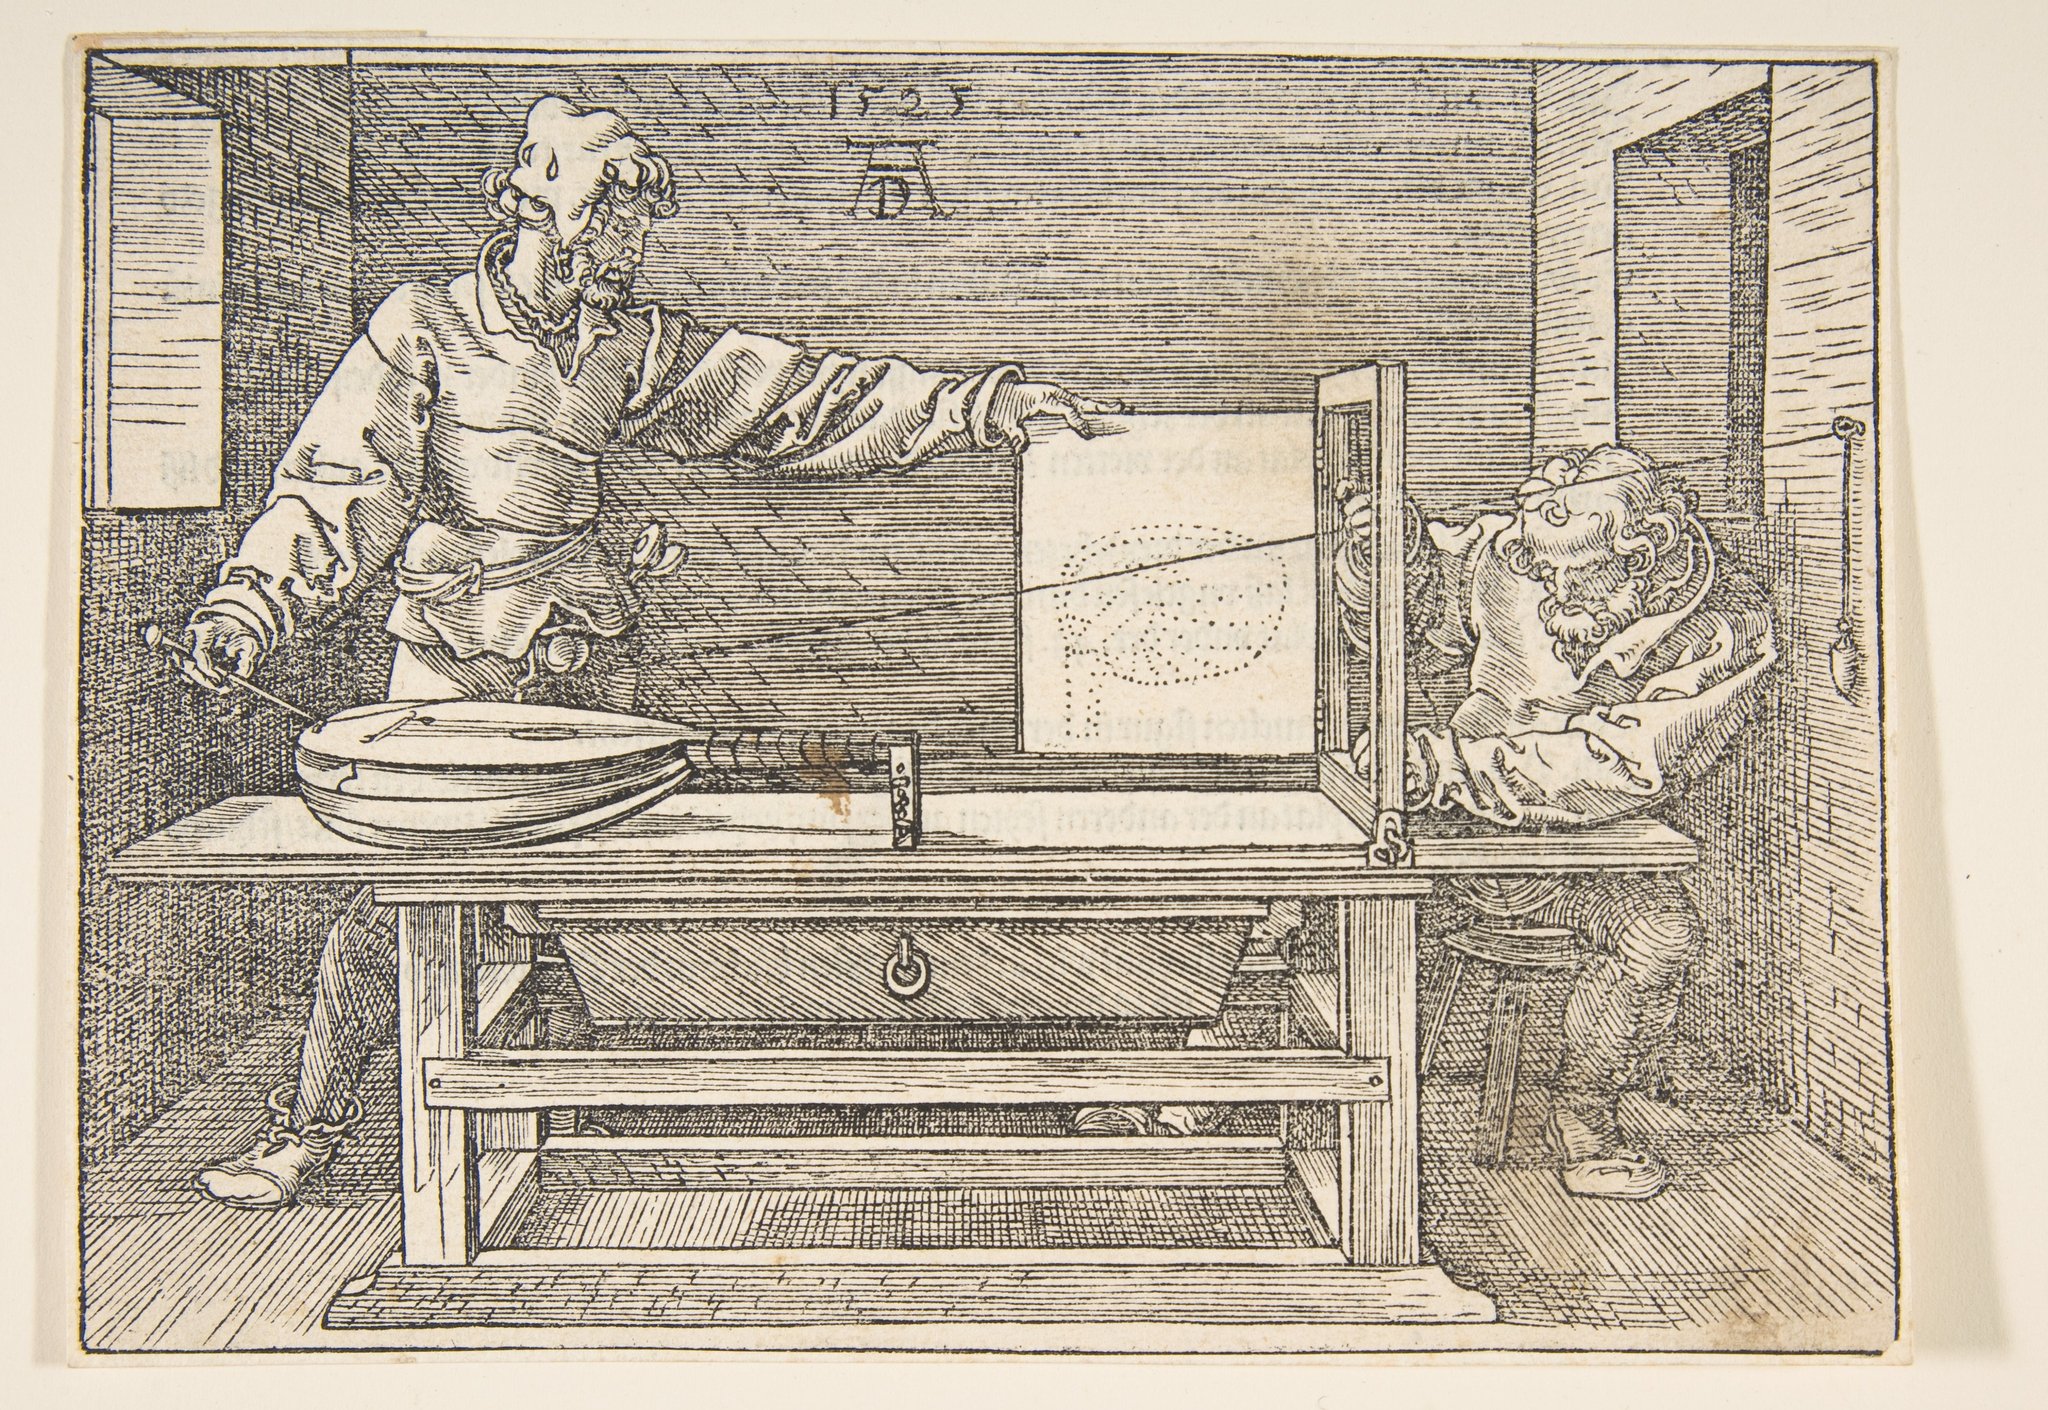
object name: print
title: The Draughtsman of the Lute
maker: albrecht dürer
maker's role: artist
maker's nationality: german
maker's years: 1471-1528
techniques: woodcut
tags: men,lutes,working